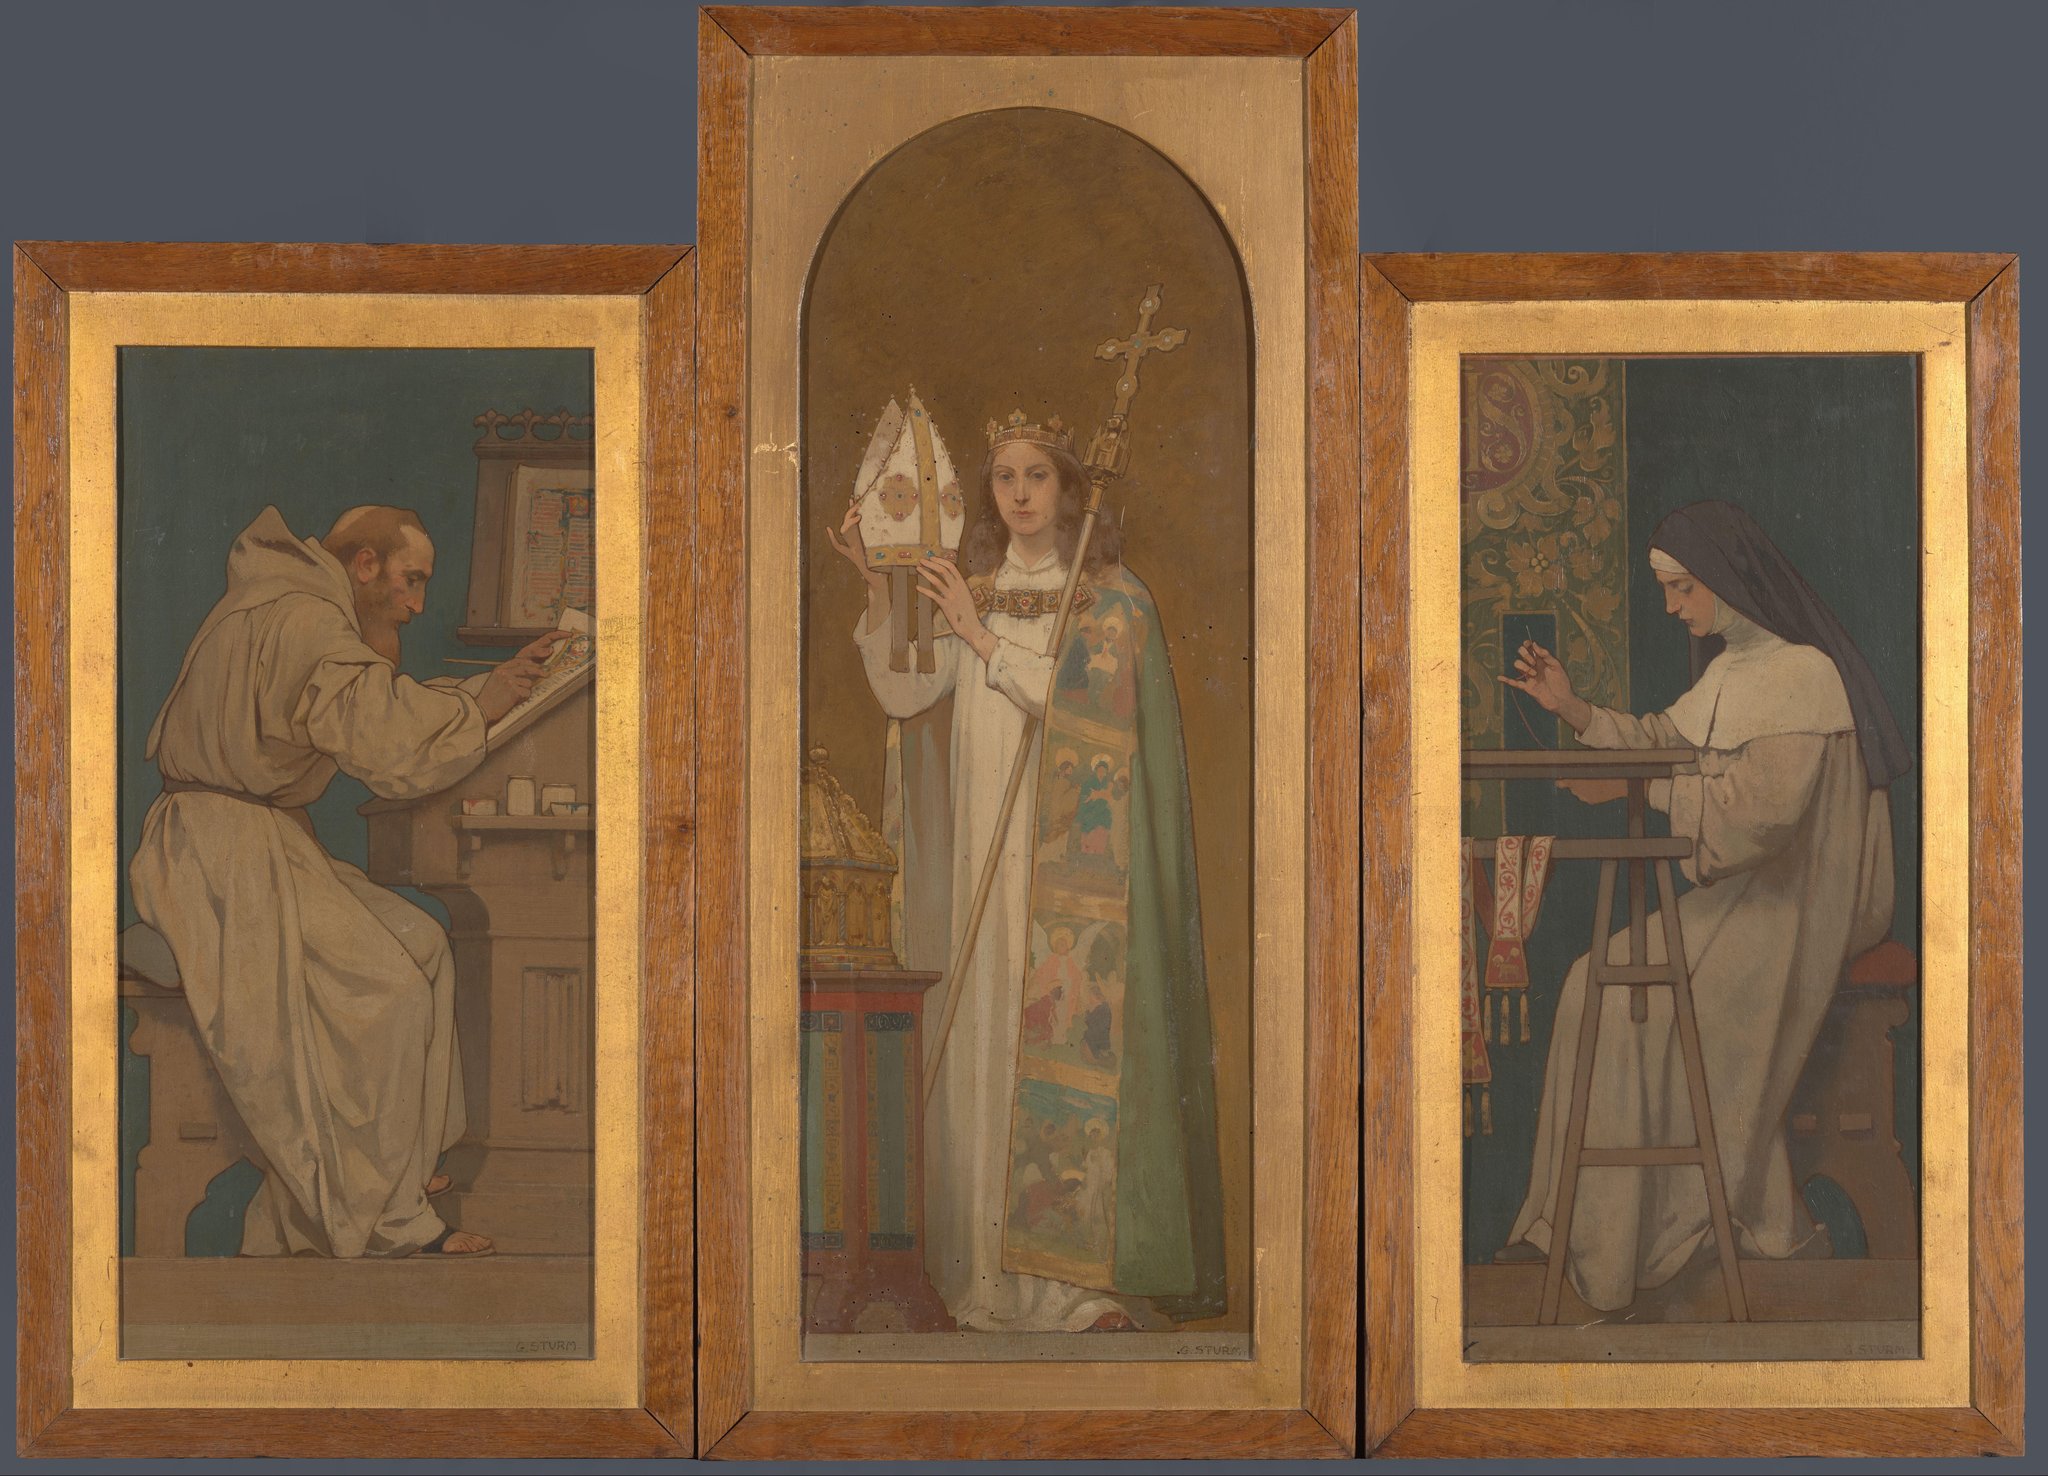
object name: triptych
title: Boekverluchting - Edelsmeedkunst - Naaldkunst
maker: georg sturm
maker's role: draughtsman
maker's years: 1855-1923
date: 1876-1885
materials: oil, paint, paper, wood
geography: amsterdam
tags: rijksmuseum amsterdam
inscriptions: signature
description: Drie voorstudies van de wandschilderingen in de Eregalerij van het Rijksmuseum, gecombineerd tot een drieluik.